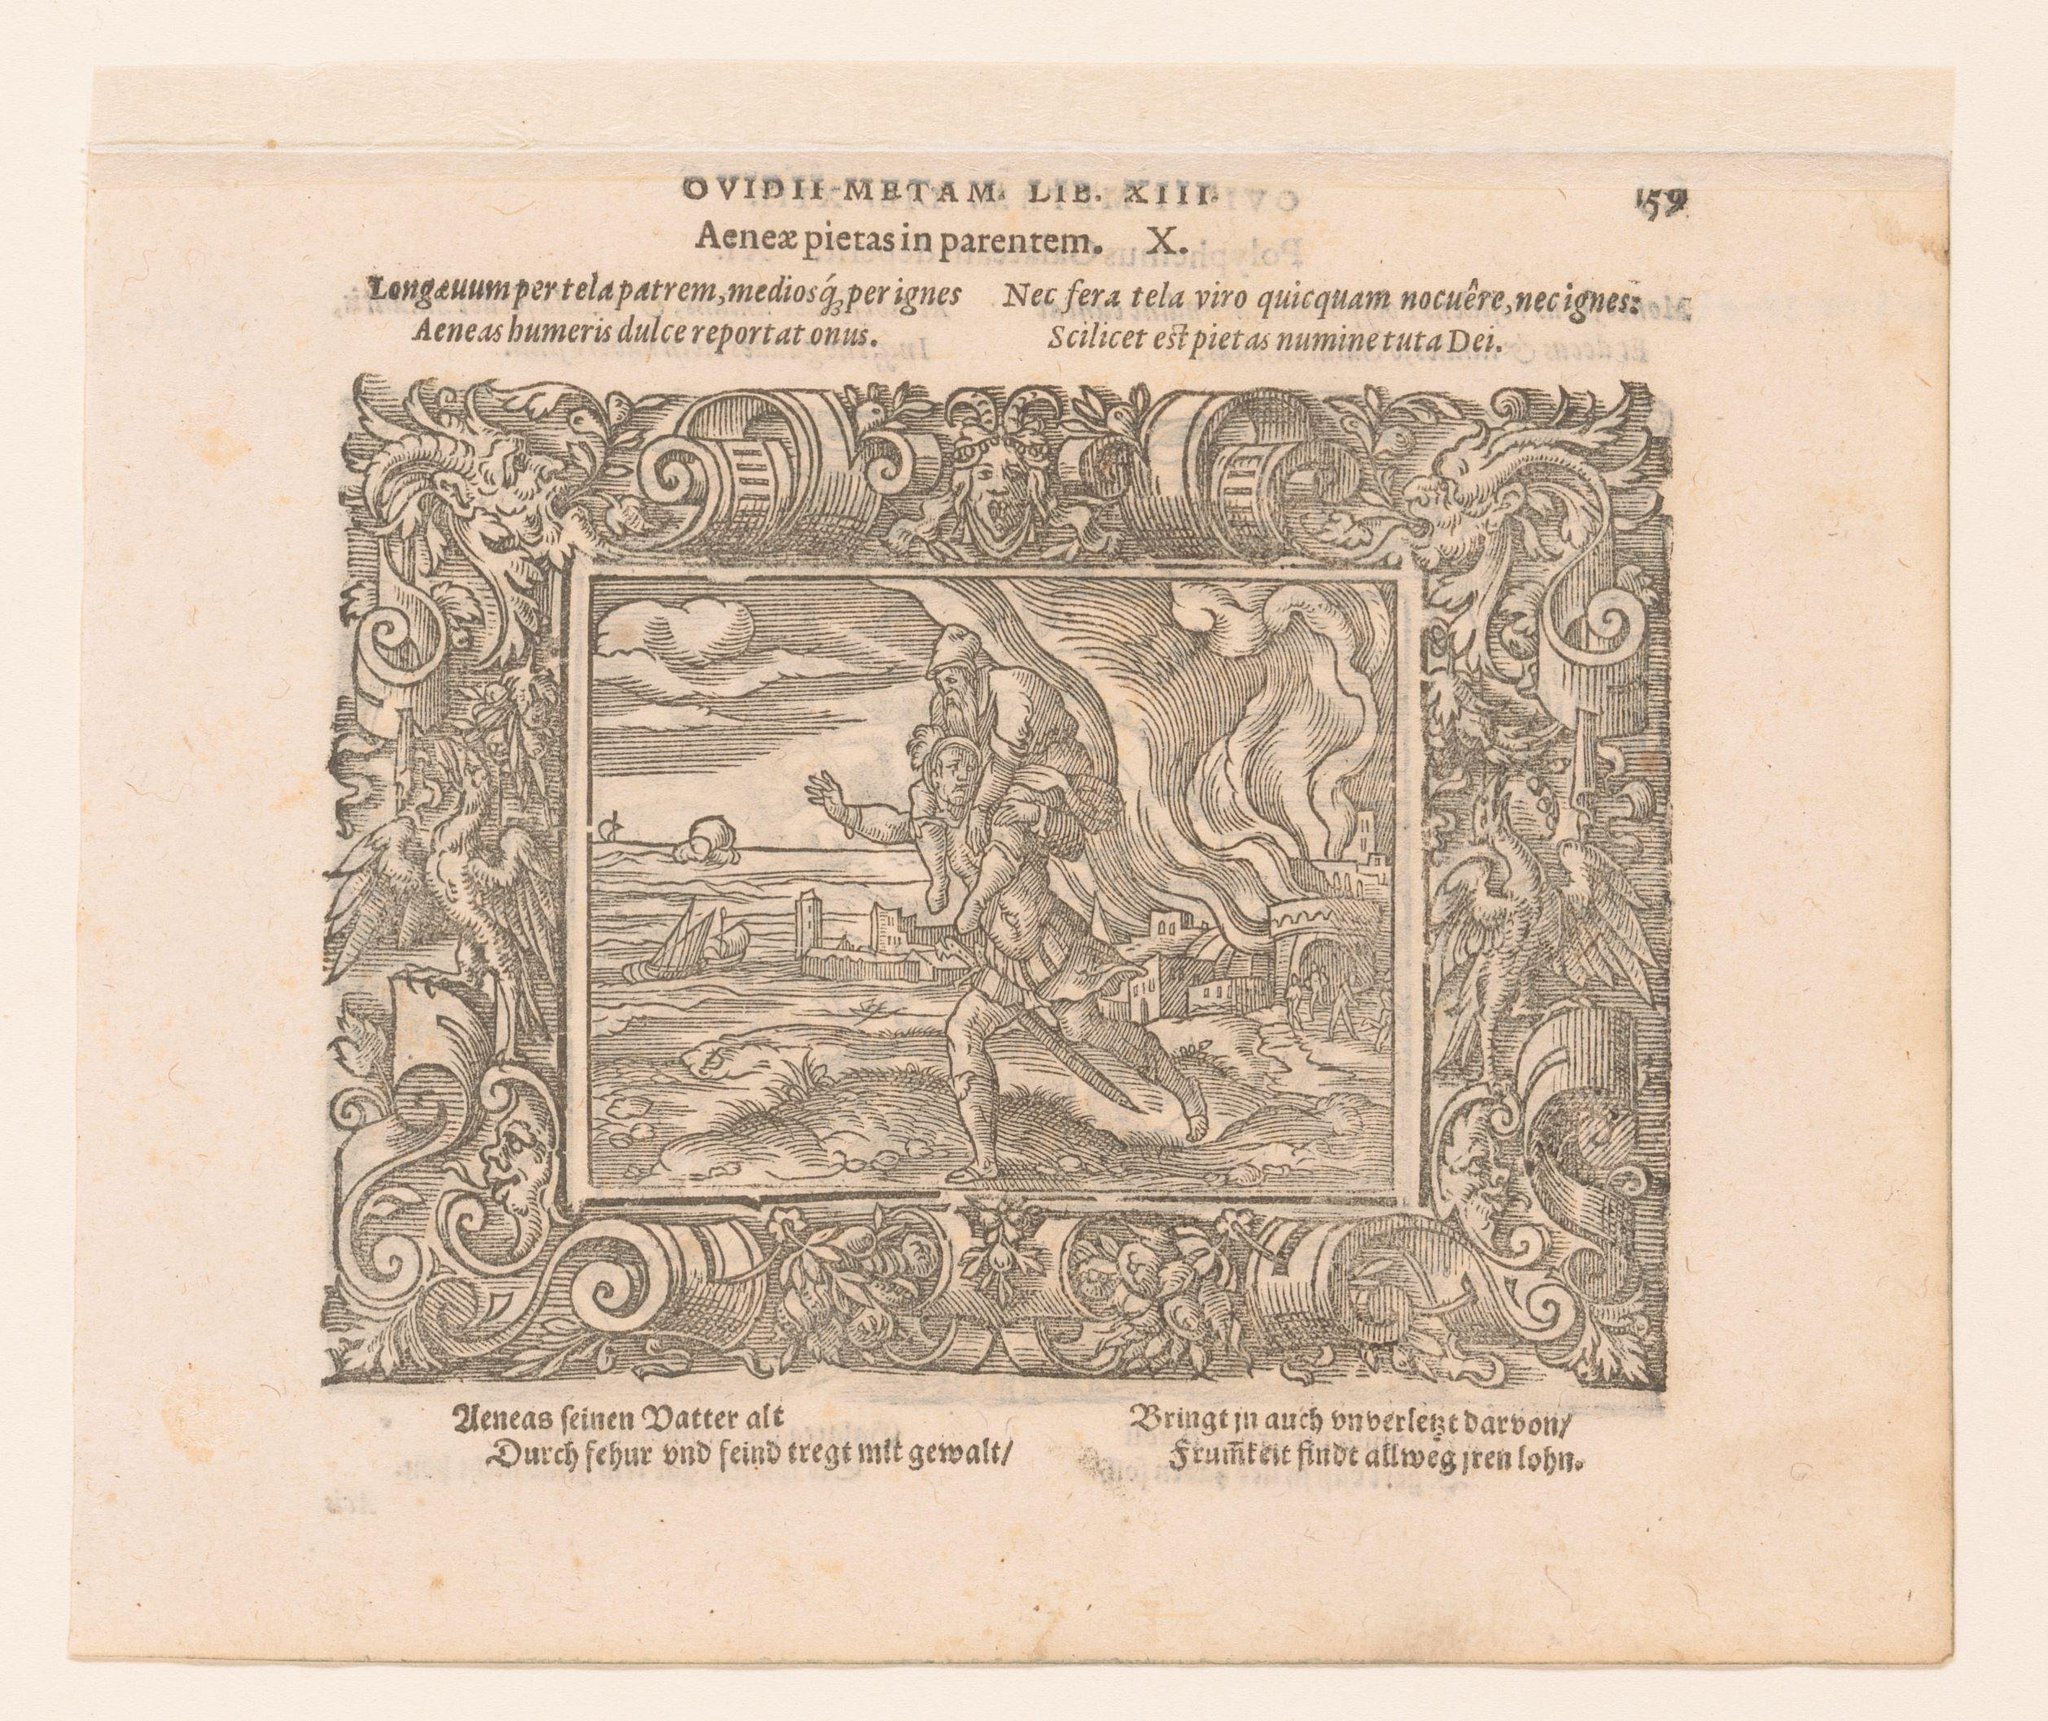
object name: print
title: Aeneae pietas in parentem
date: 1569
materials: paper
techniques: letterpress printing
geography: frankfurt am main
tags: scrollwork, strapwork ~ ornament, 'pius aeneas': aeneas, leading ascanius, escapes from burning troy, carrying his father anchises with the penates; his wife creusa, who sets out with them, is lost on the way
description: Illustratie bij de Metamorfosen van Ovidius, afkomstig uit de publicatie: Posthius, Johannes. Tetrasticha in Ovidii metam. Frankfurt am Main: Georg Rab en Sigmund Feyerabend en erven Weigand Han, 1569. De voorstellingen en ornamentranden van deze boekillustraties zijn van twee aparte blokken gedrukt. Beide werden afzonderlijk van elkaar ook gebruikt voor andere publicaties, en de ornamentranden werden eveneens binnen deze publicatie meerdere keren gebruikt.